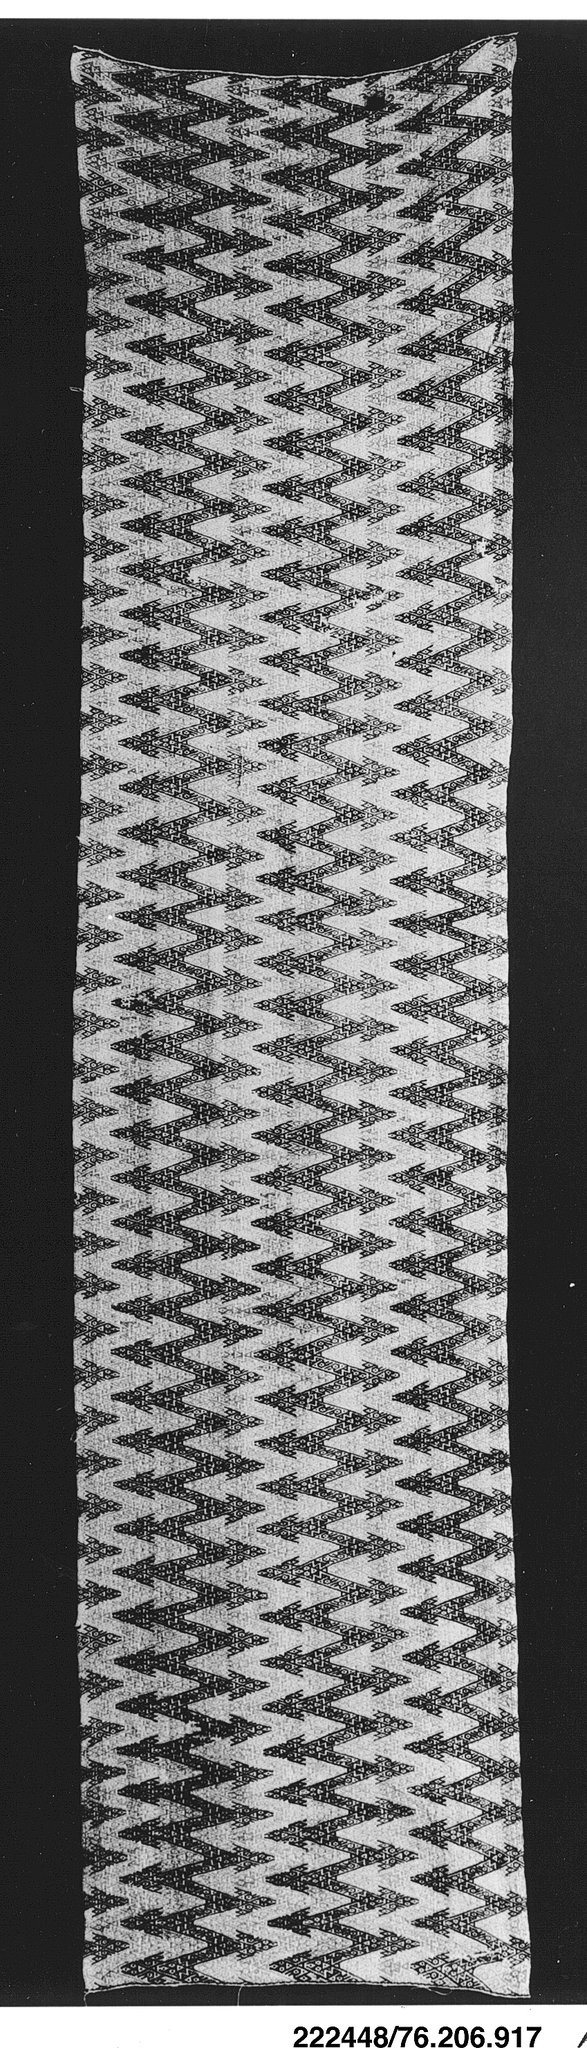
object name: panel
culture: chancay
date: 1401-1600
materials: animal fiber, cotton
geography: peru